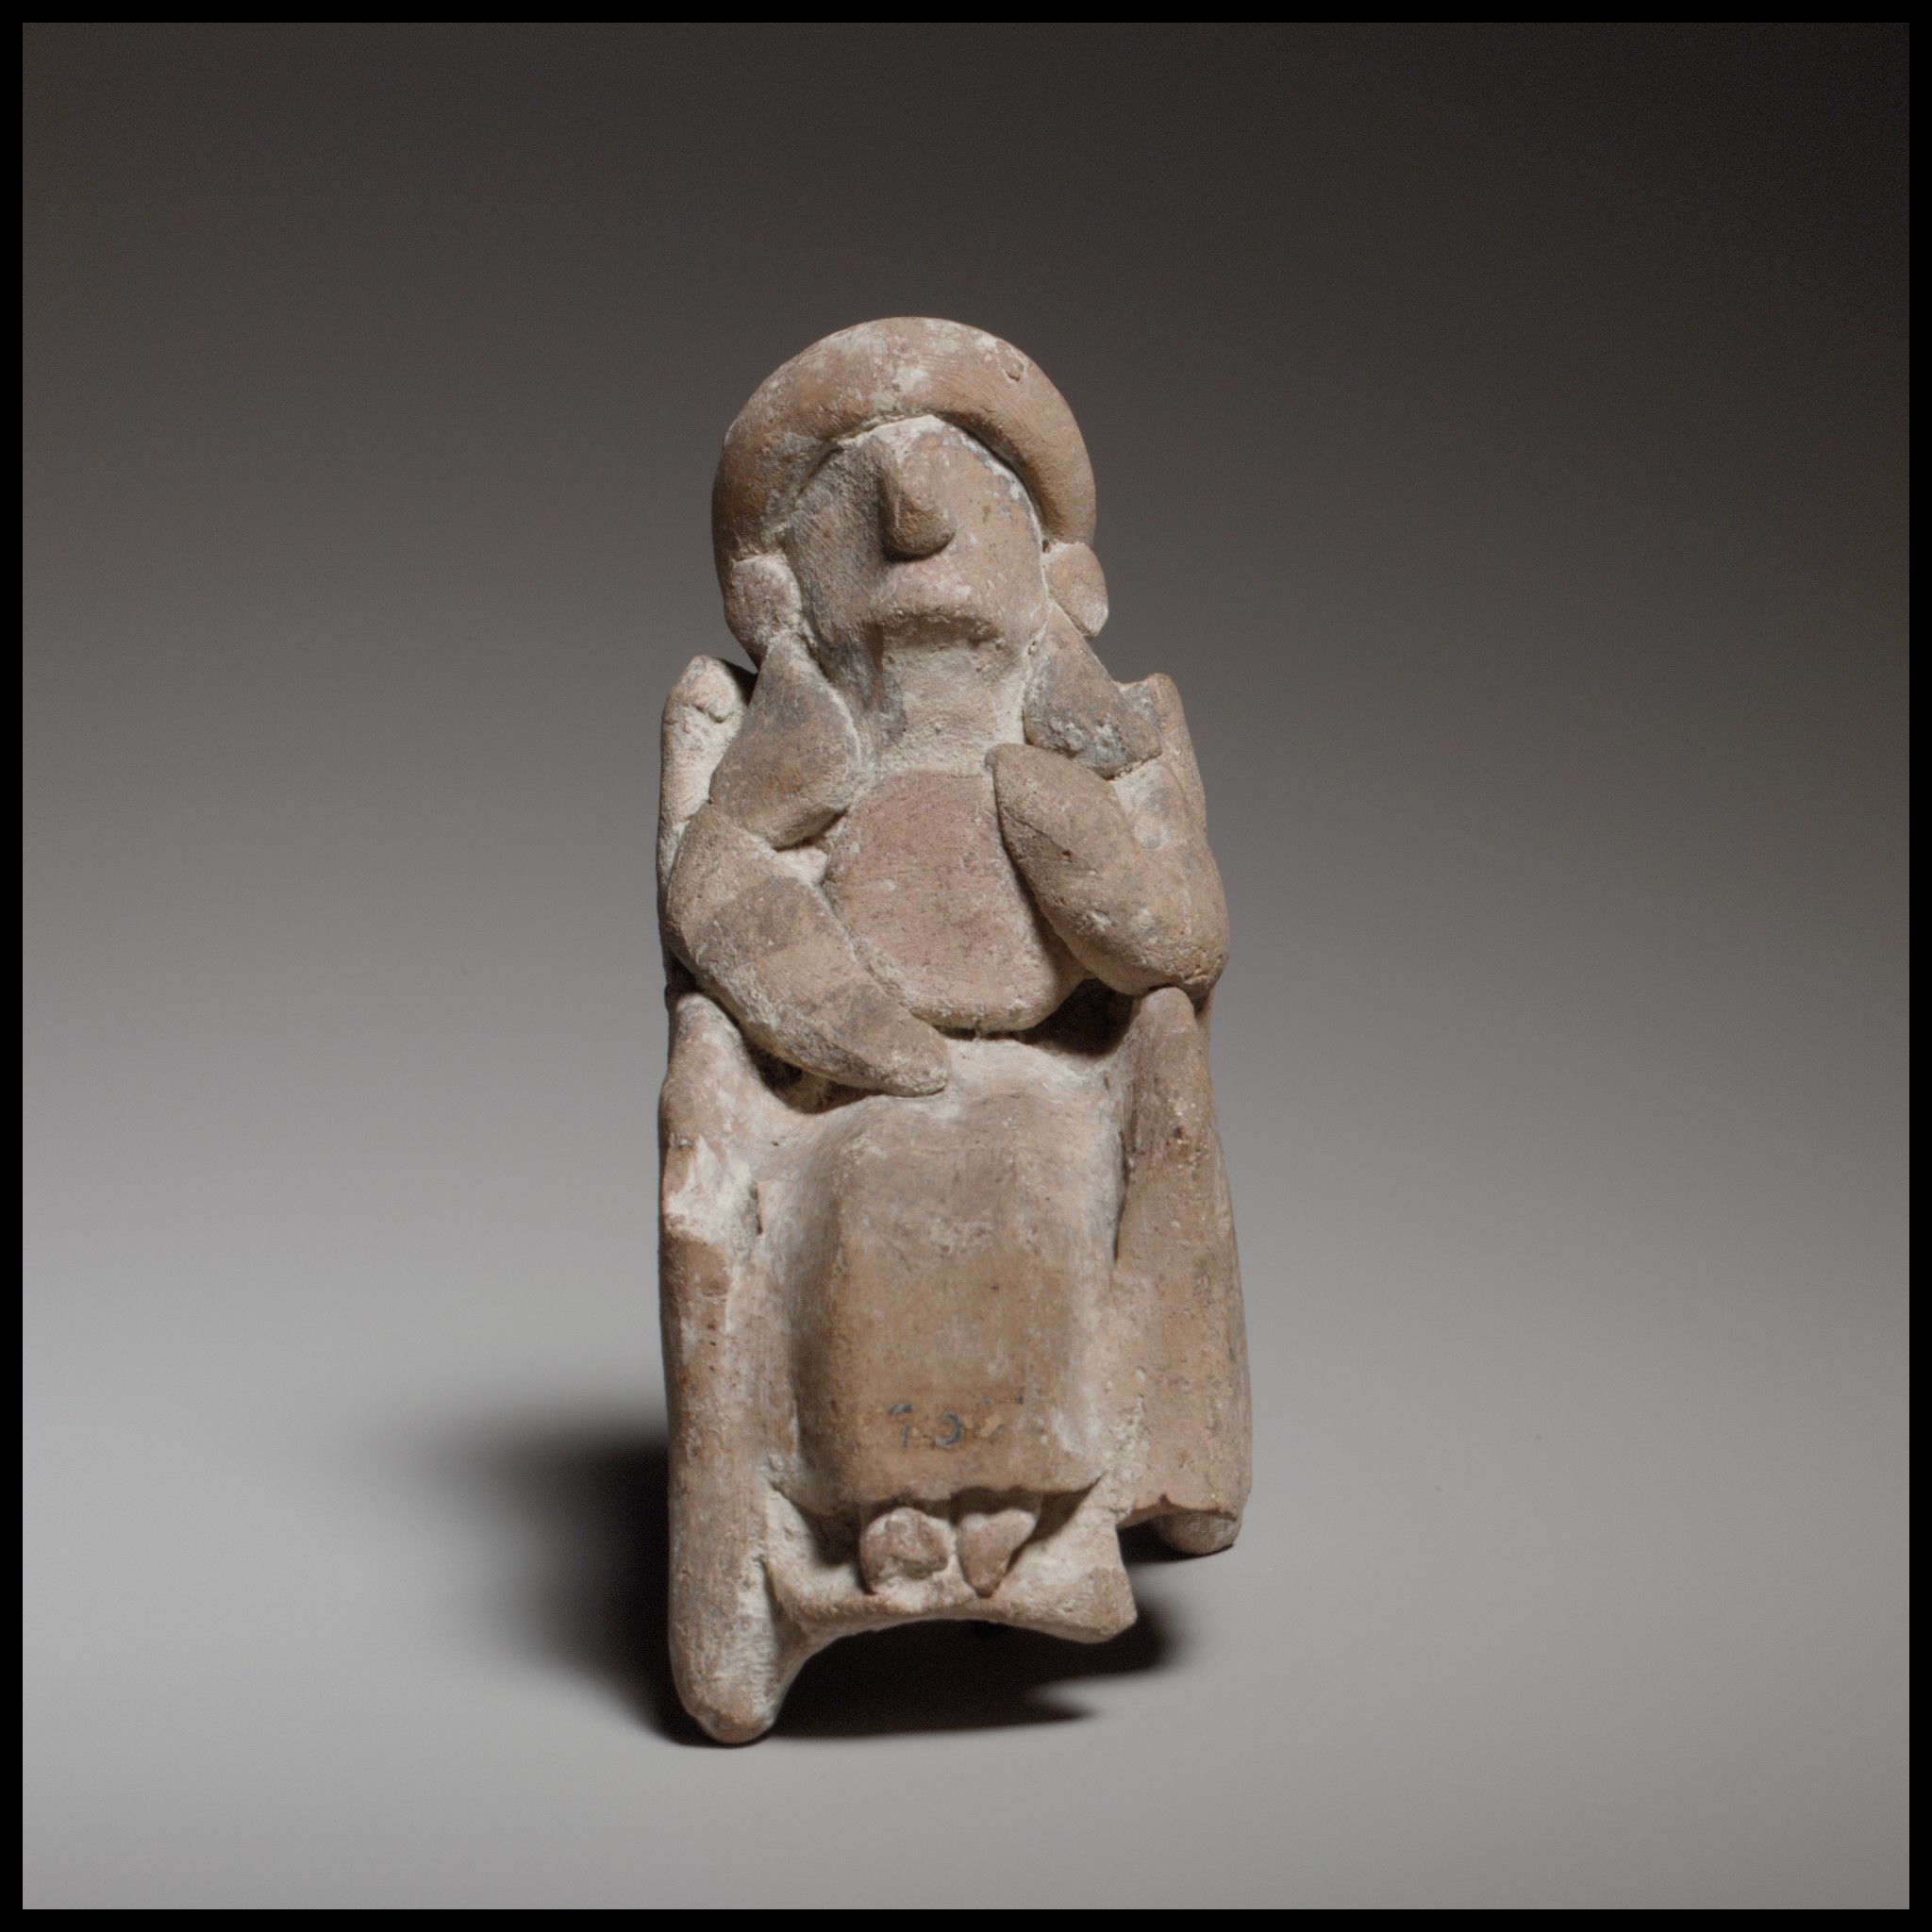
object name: statuette of a woman with tympanon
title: Seated female figurine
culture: cypriot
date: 534-468 BCE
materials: terracotta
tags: women